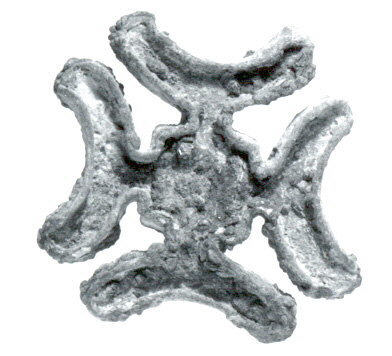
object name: stamp seal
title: Compartmented stamp seal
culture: bactria-margiana archaeological complex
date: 2333-1668 BCE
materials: copper alloy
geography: bactria-margiana